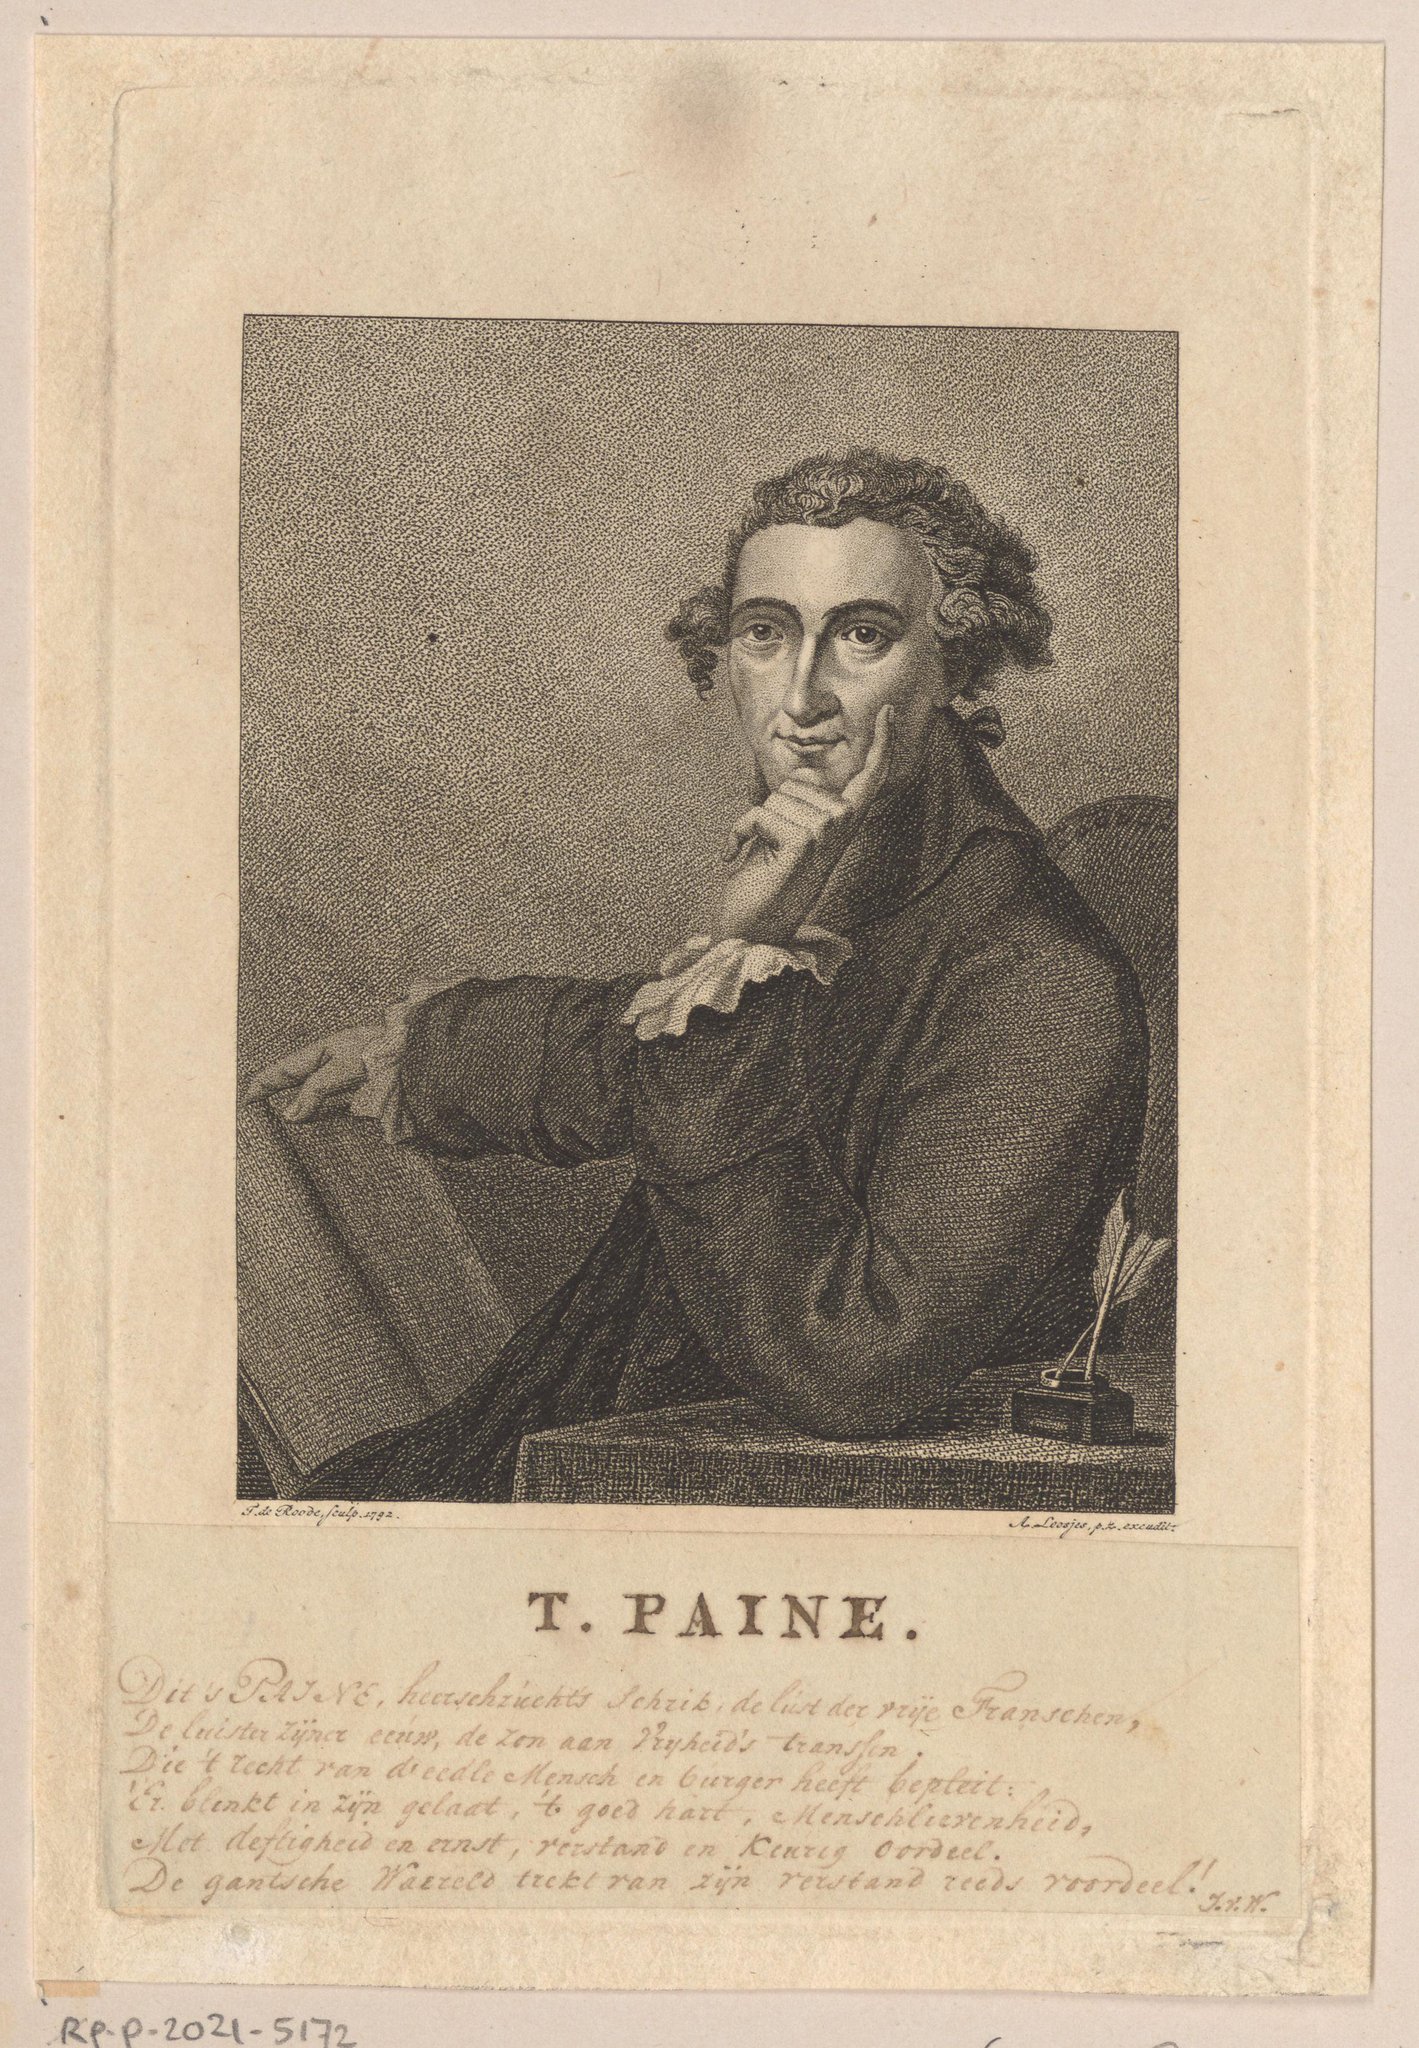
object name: print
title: Portret van Thomas Paine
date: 1792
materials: ink, paper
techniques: engraving, etching, pen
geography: haarlem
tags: new york (city), adult man, historical persons, book - mm - book open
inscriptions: inscription: ‘Dit is Paine, heerschzicht's schrik (...) voordeel! J.v.W.’